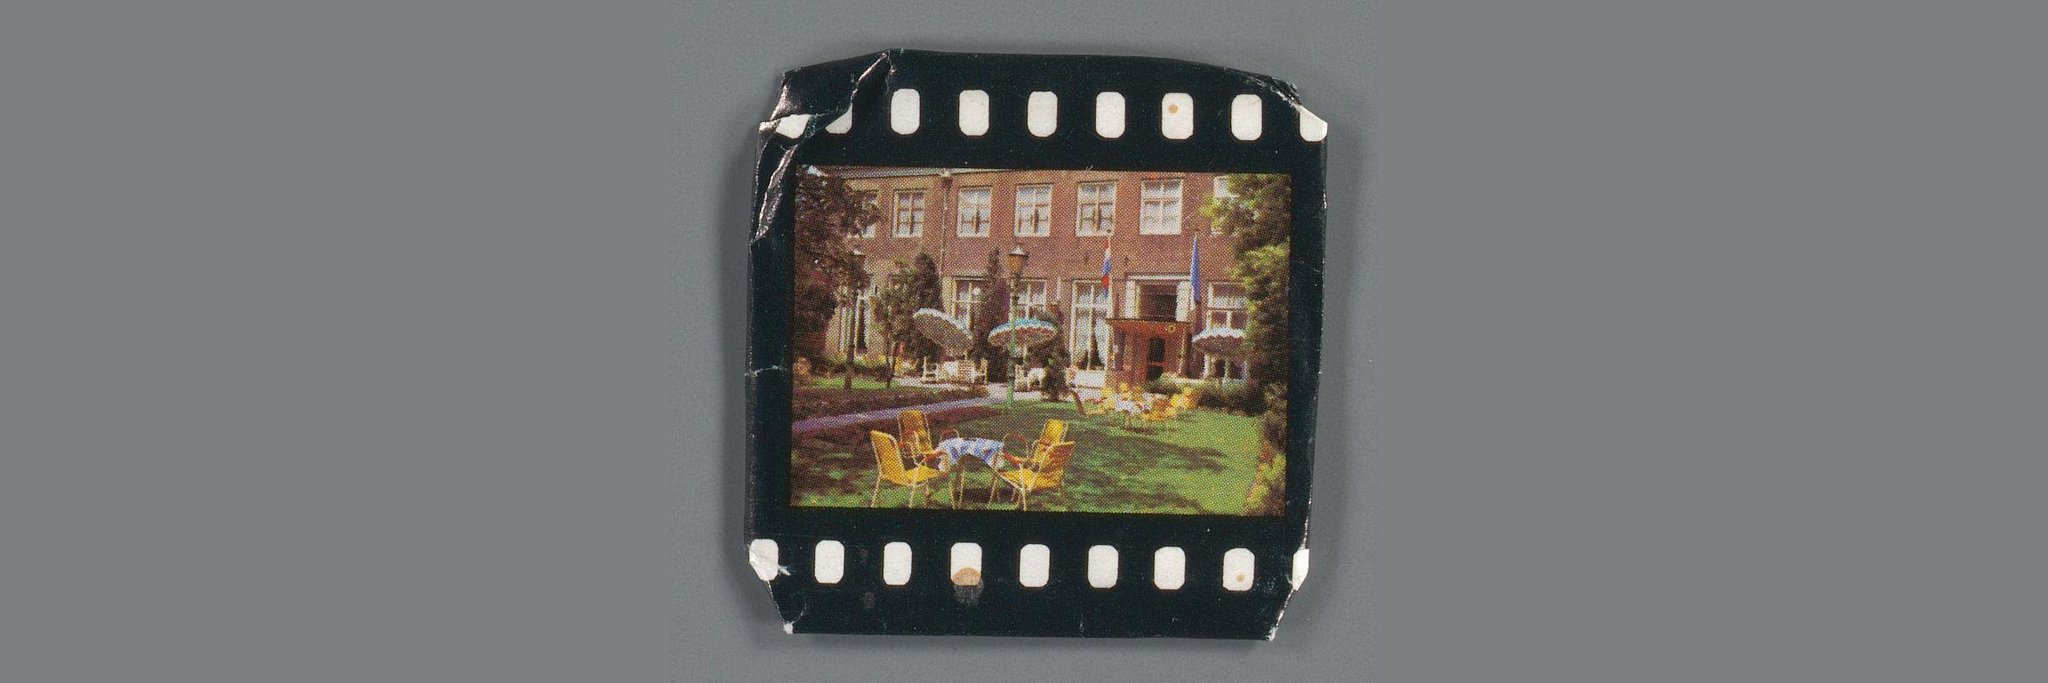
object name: wrapper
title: Wikkel in de vorm van een filmstrip, met een voorstelling van het terras van hotel-restaurant 's-Gravenhof te Zutphen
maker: Anonymous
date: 1950-1980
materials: paper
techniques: offset printed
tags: pavement, terrace in front of inn or restaurant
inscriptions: inscription: ‘Hotel-Restaurant/ 's-Gravenhof/ Zutphen/ tel.: 05750-3917’